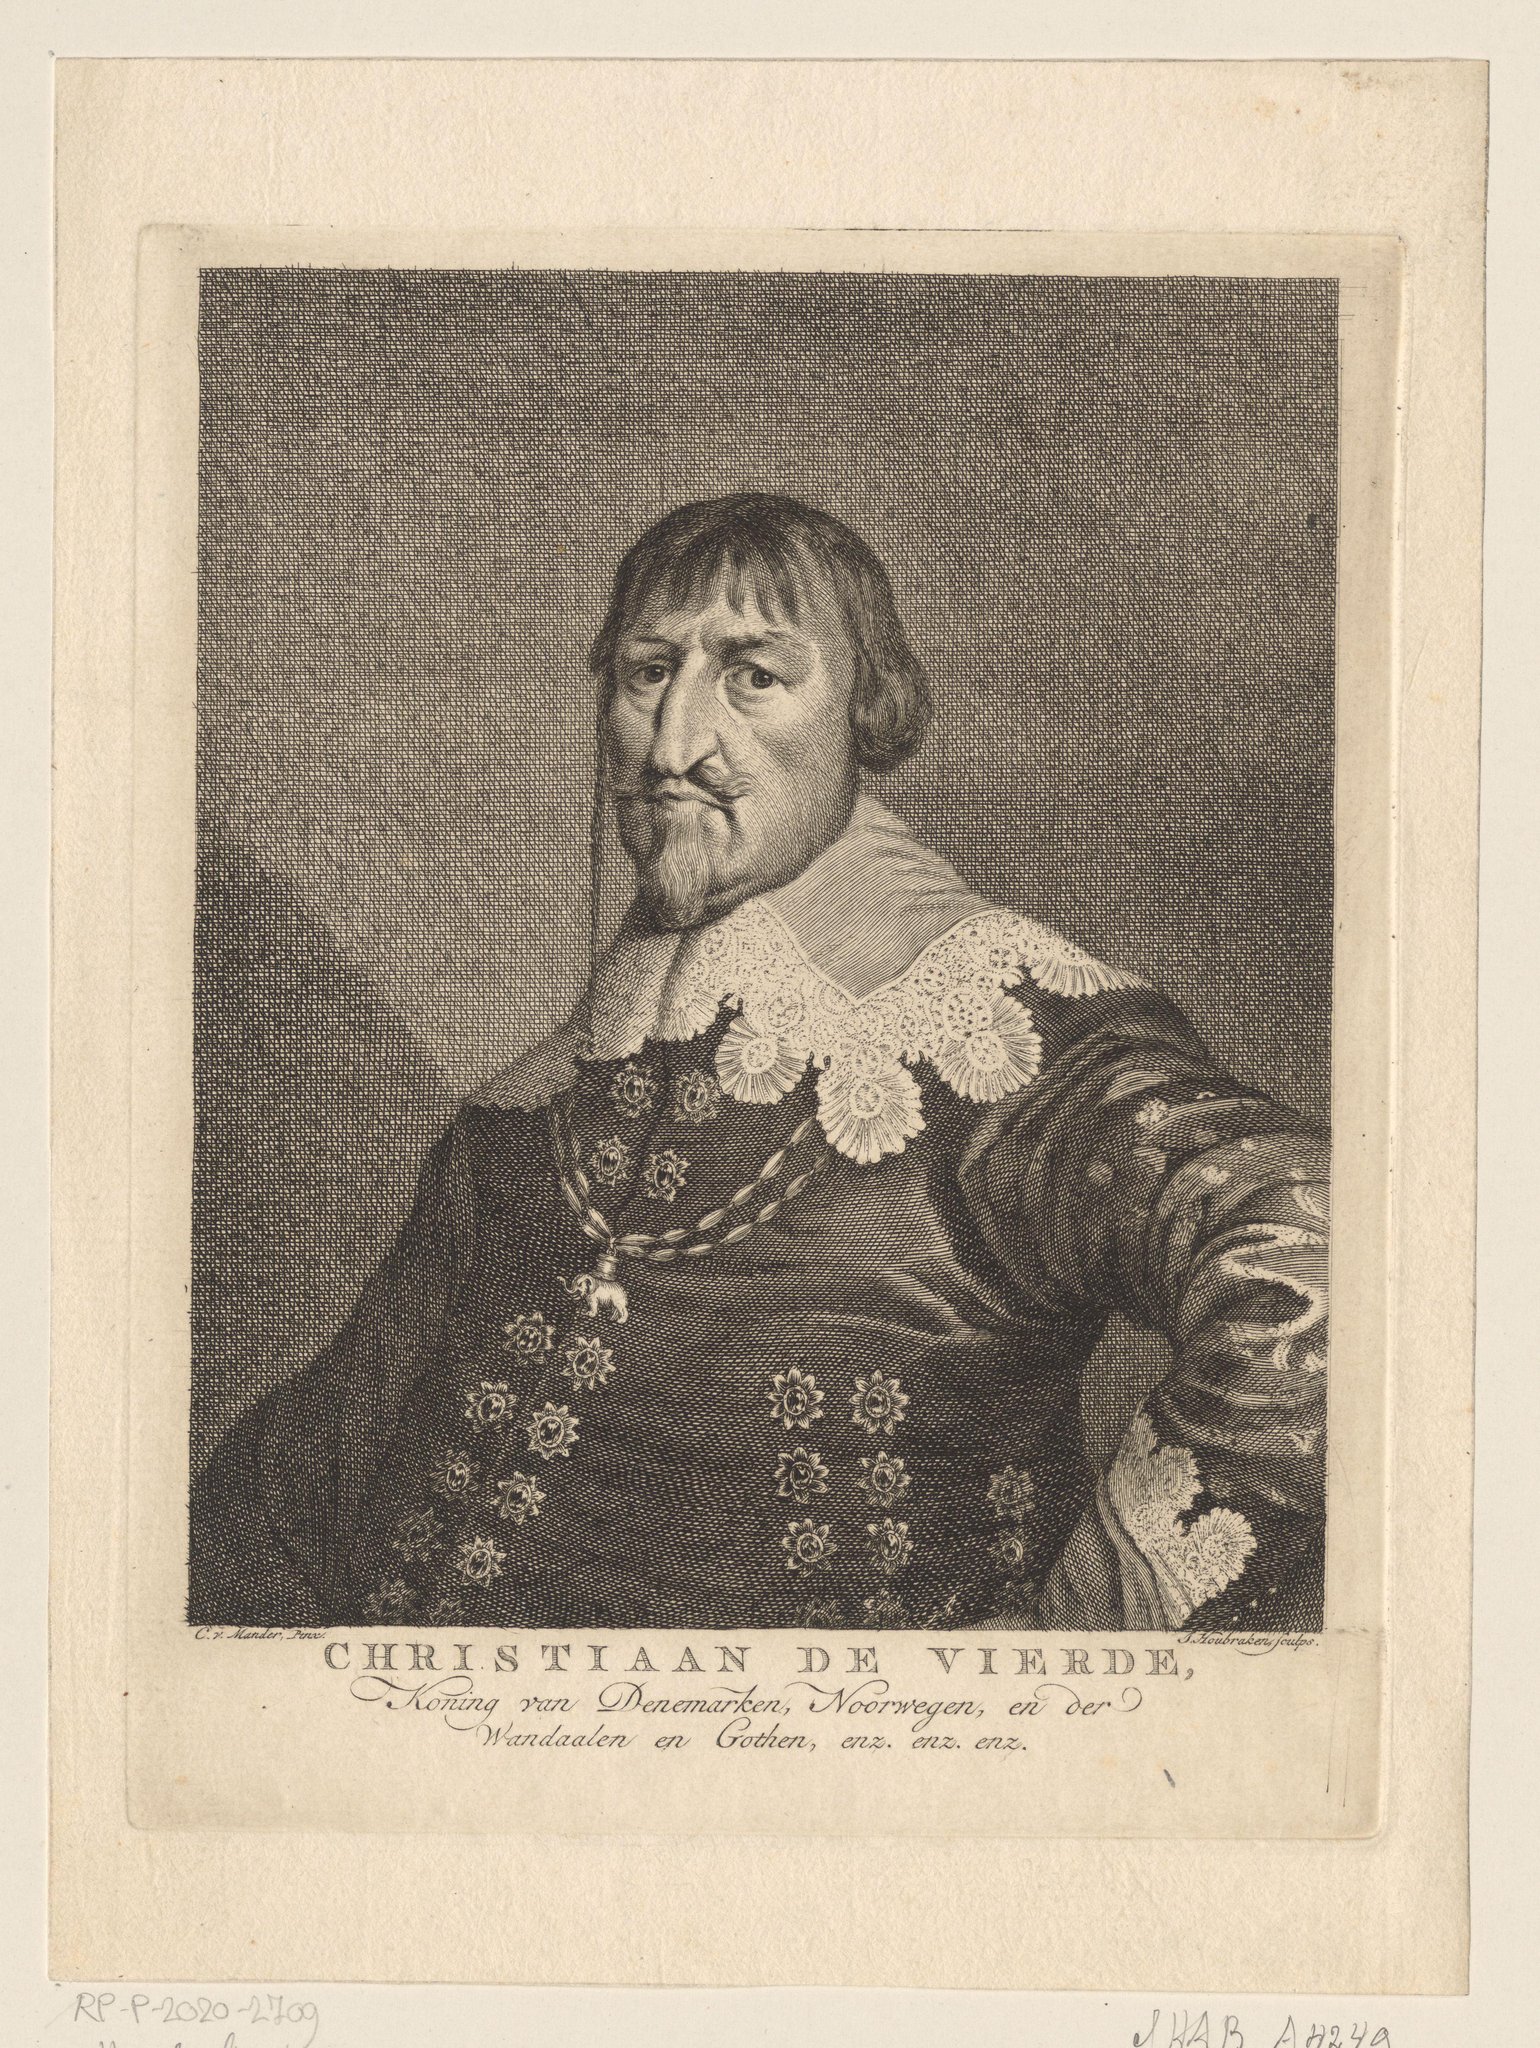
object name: print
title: Portret van Christiaan IV, koning van Denemarken en Noorwegen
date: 1710-1780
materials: paper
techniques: engraving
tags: copenhagen (city), christiaan iv (koning van denemarken en noorwegen), historical persons, king